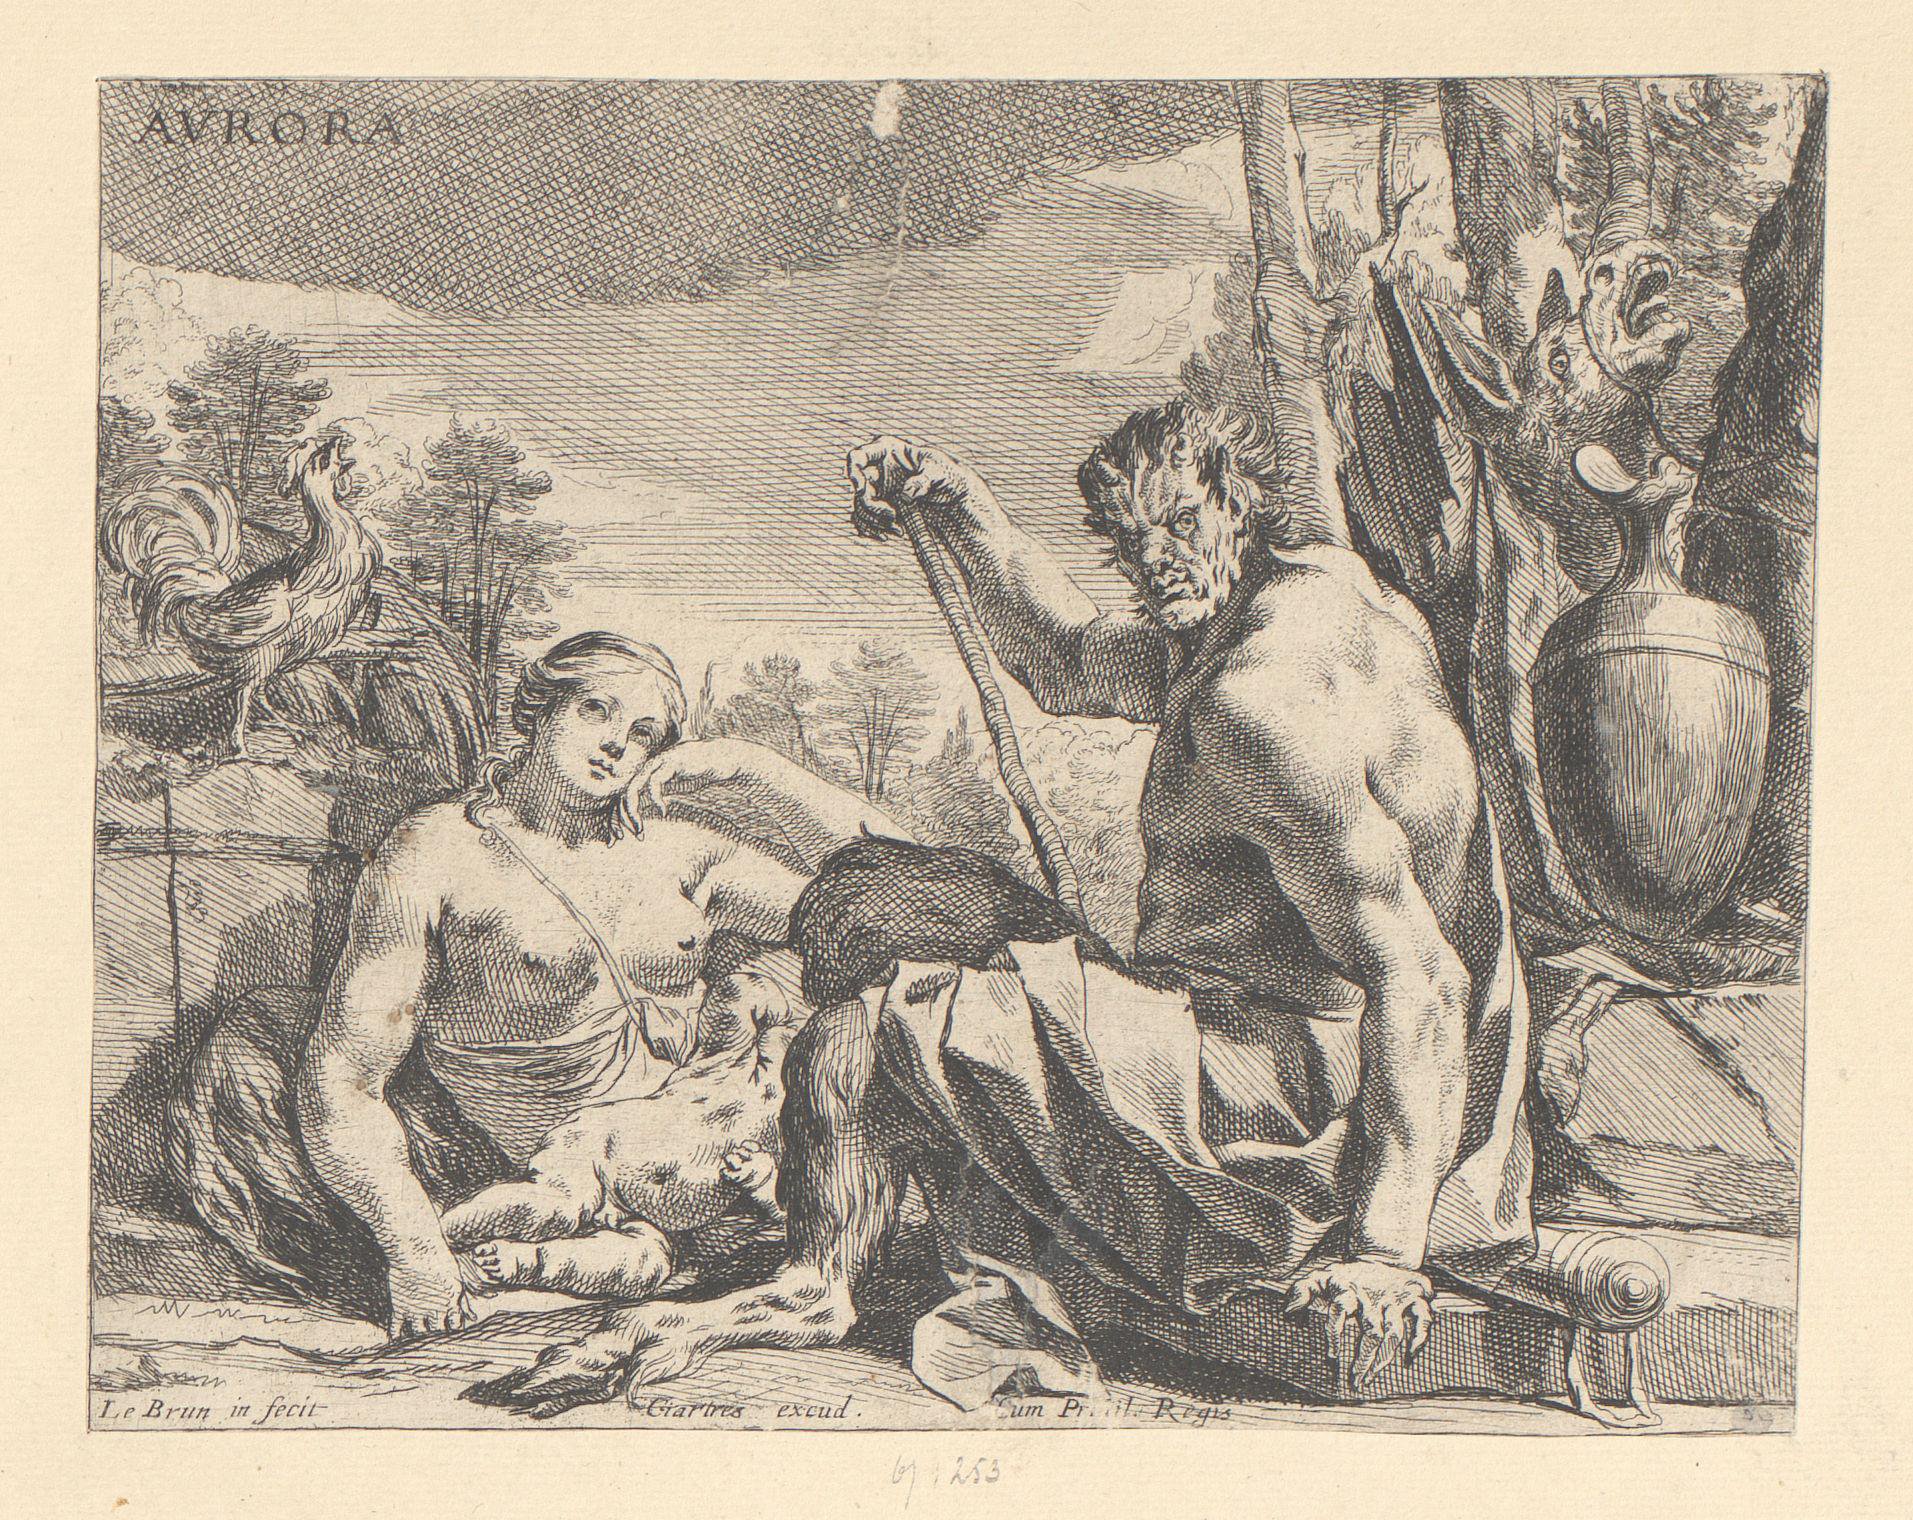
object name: print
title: Werken van Charles le Brun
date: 1629-1690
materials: paper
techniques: etching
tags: dawn, fowl (cock, hen, chicken, etc.), personification of the morning, 'aurora'; 'aurora' (ripa)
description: Deze prent maakt deel uit van een album.